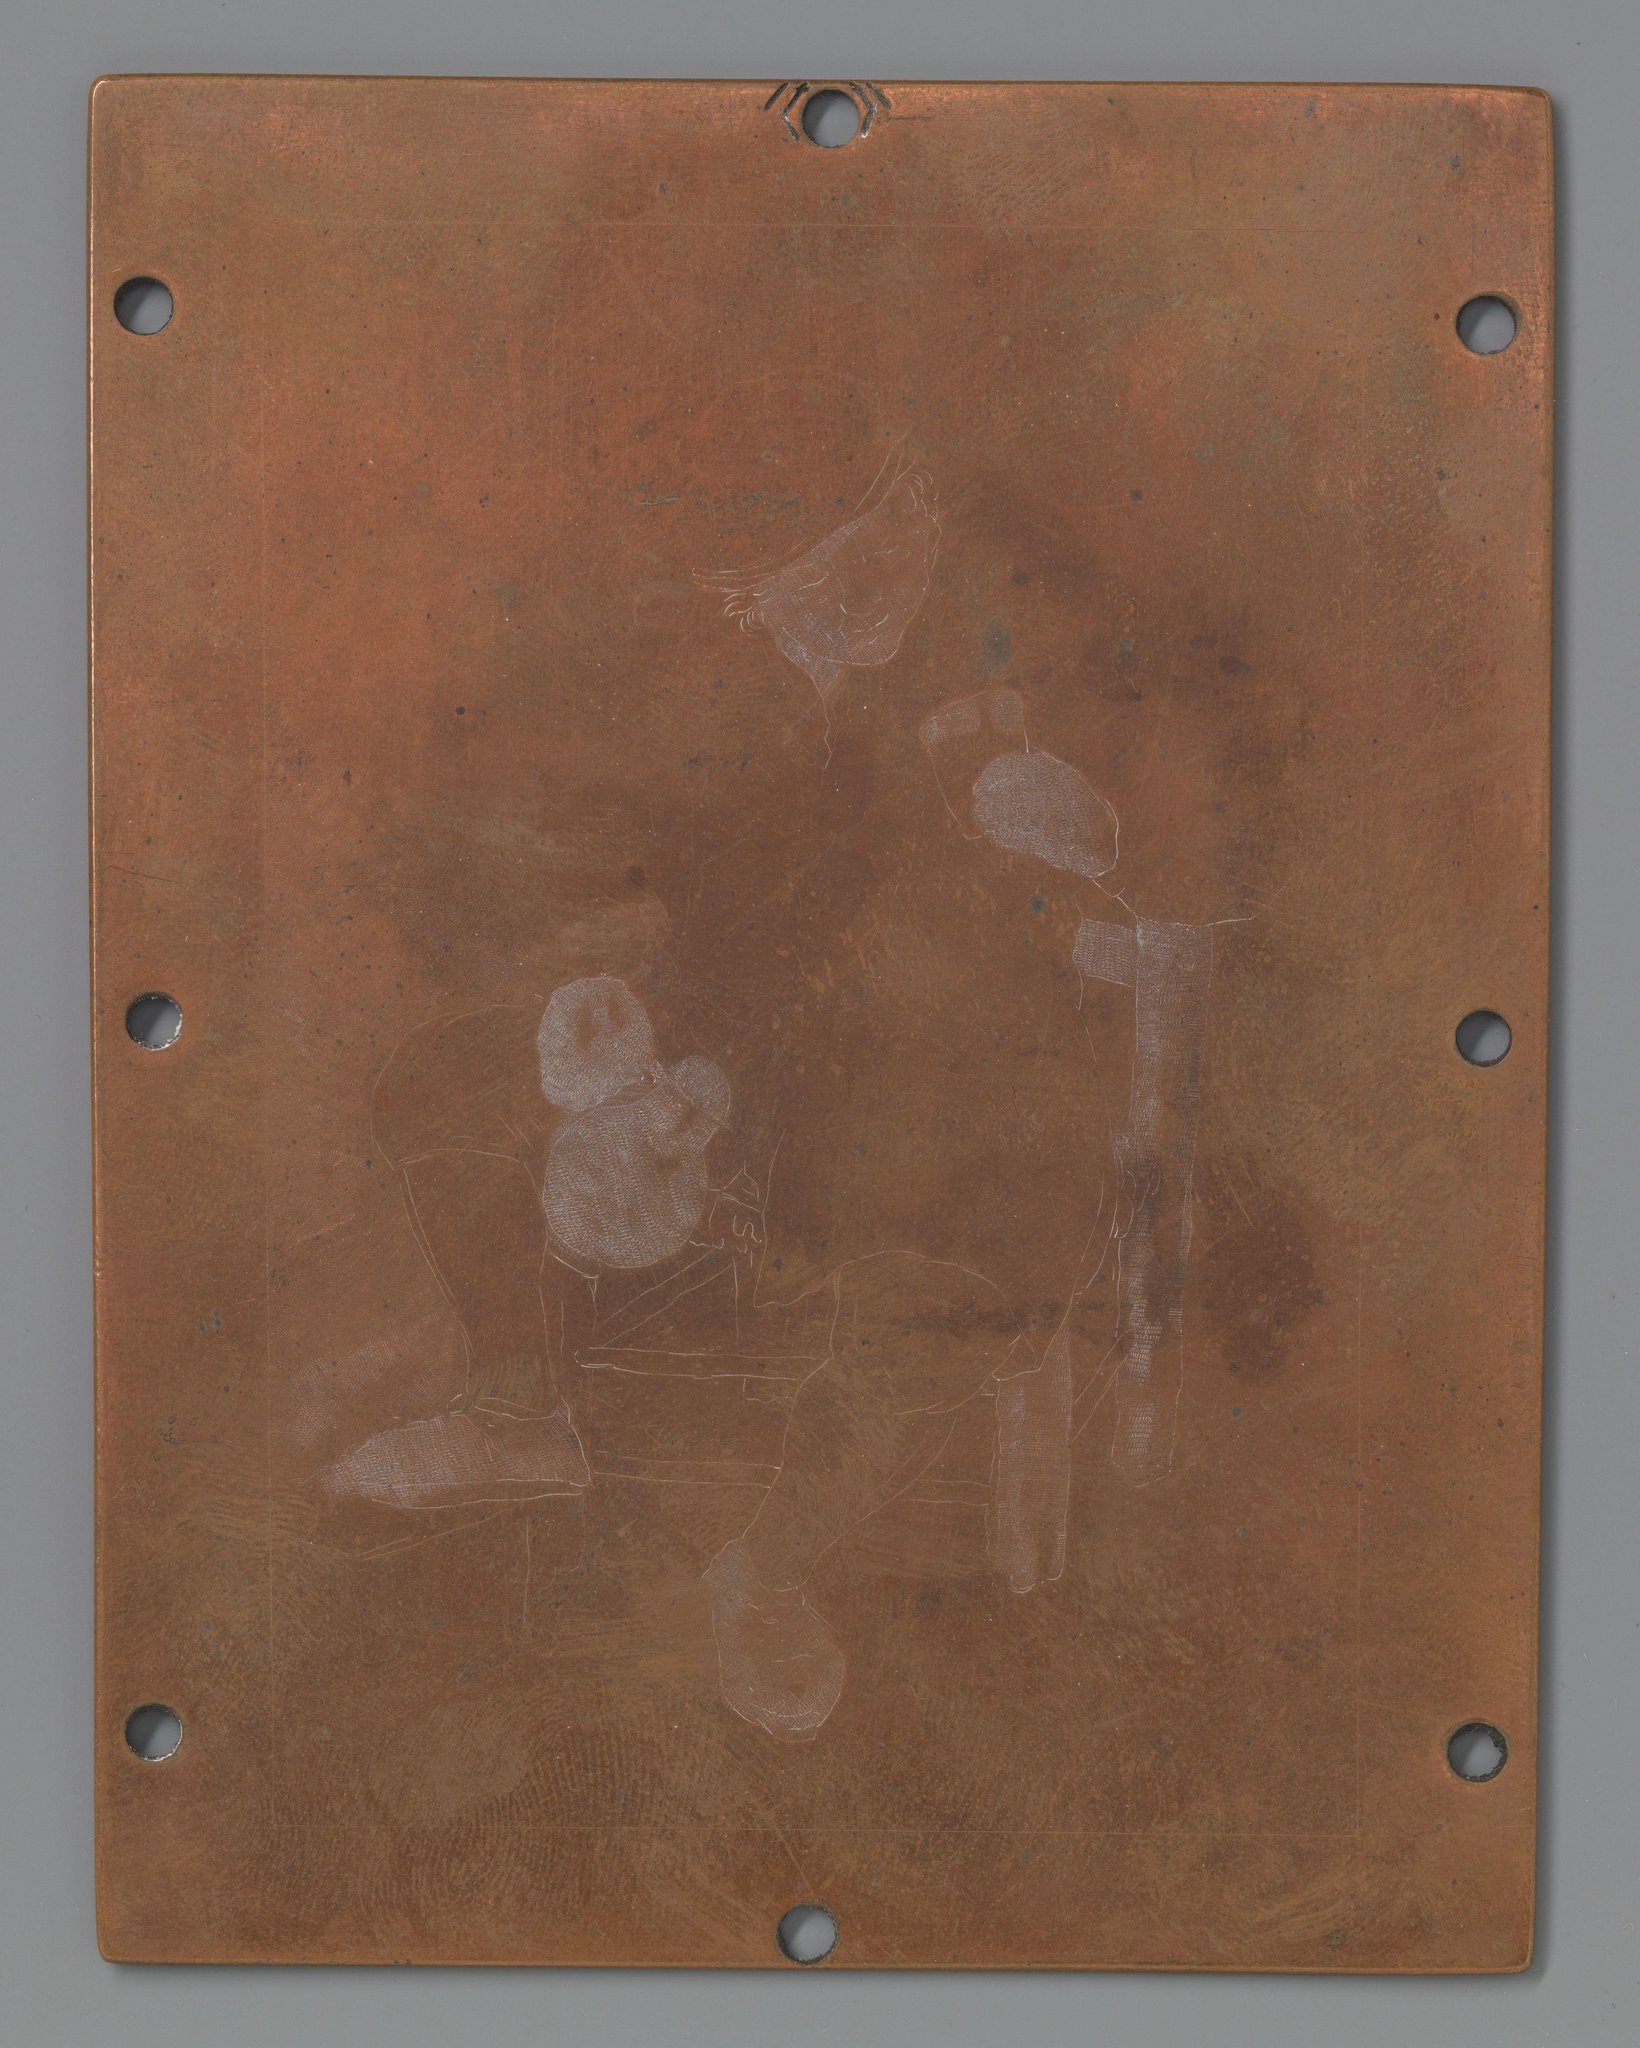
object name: copper plate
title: Zittende boer met kruik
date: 1763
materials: copper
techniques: etching, roulette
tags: sitting figure, jar, jug (used as drinking-vessel), farmers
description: Voor de prenttekening 'Zittende boer met kruik' maakte Ploos van Amstel vier verschillende platen (A, B, C, en D). Dit is plaat A. Er bestaan afdrukken van één, twee, drie of alle vier de platen in alle mogelijke combinaties. Voor afdrukken van alleen deze plaat, zie RP-P-1893-A-17955 en RP-P-1893-A-17940.